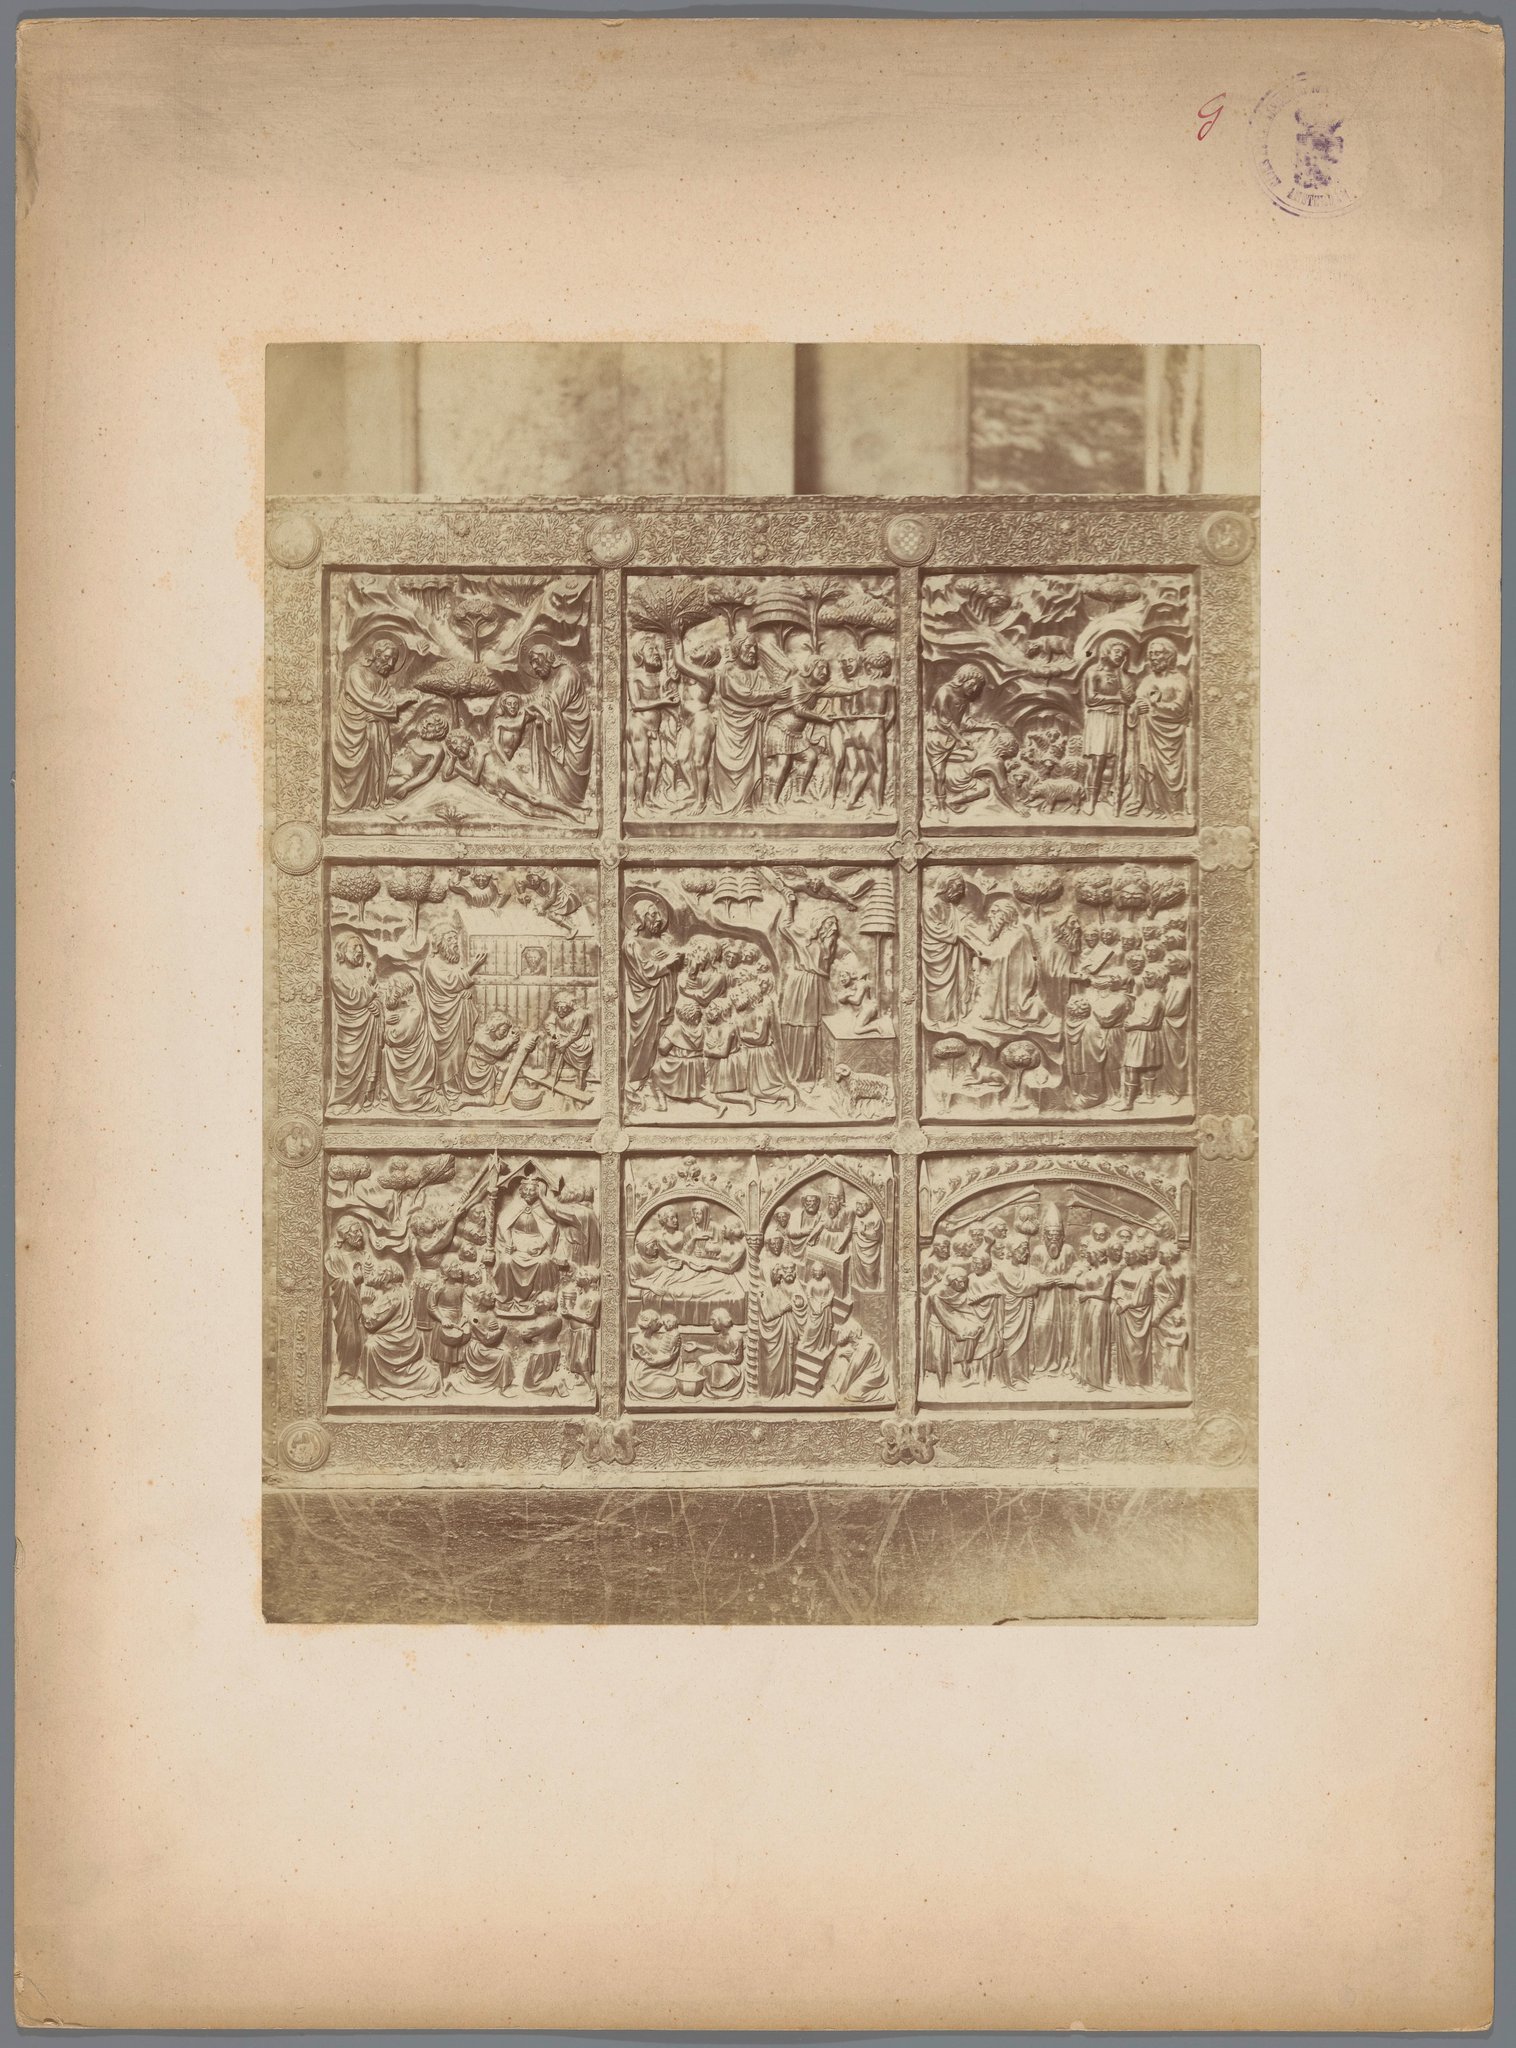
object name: photograph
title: Bronzen paneel met 9 Bijbelse voorstellingen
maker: Anonymous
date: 1850-1900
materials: cardboard, photographic support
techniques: albumen print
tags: series of scenes from the life of christ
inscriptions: inscription: ‘G’, collector's mark: ‘Rijks normaalschool voor teekenonderwijzers Amsterdam’